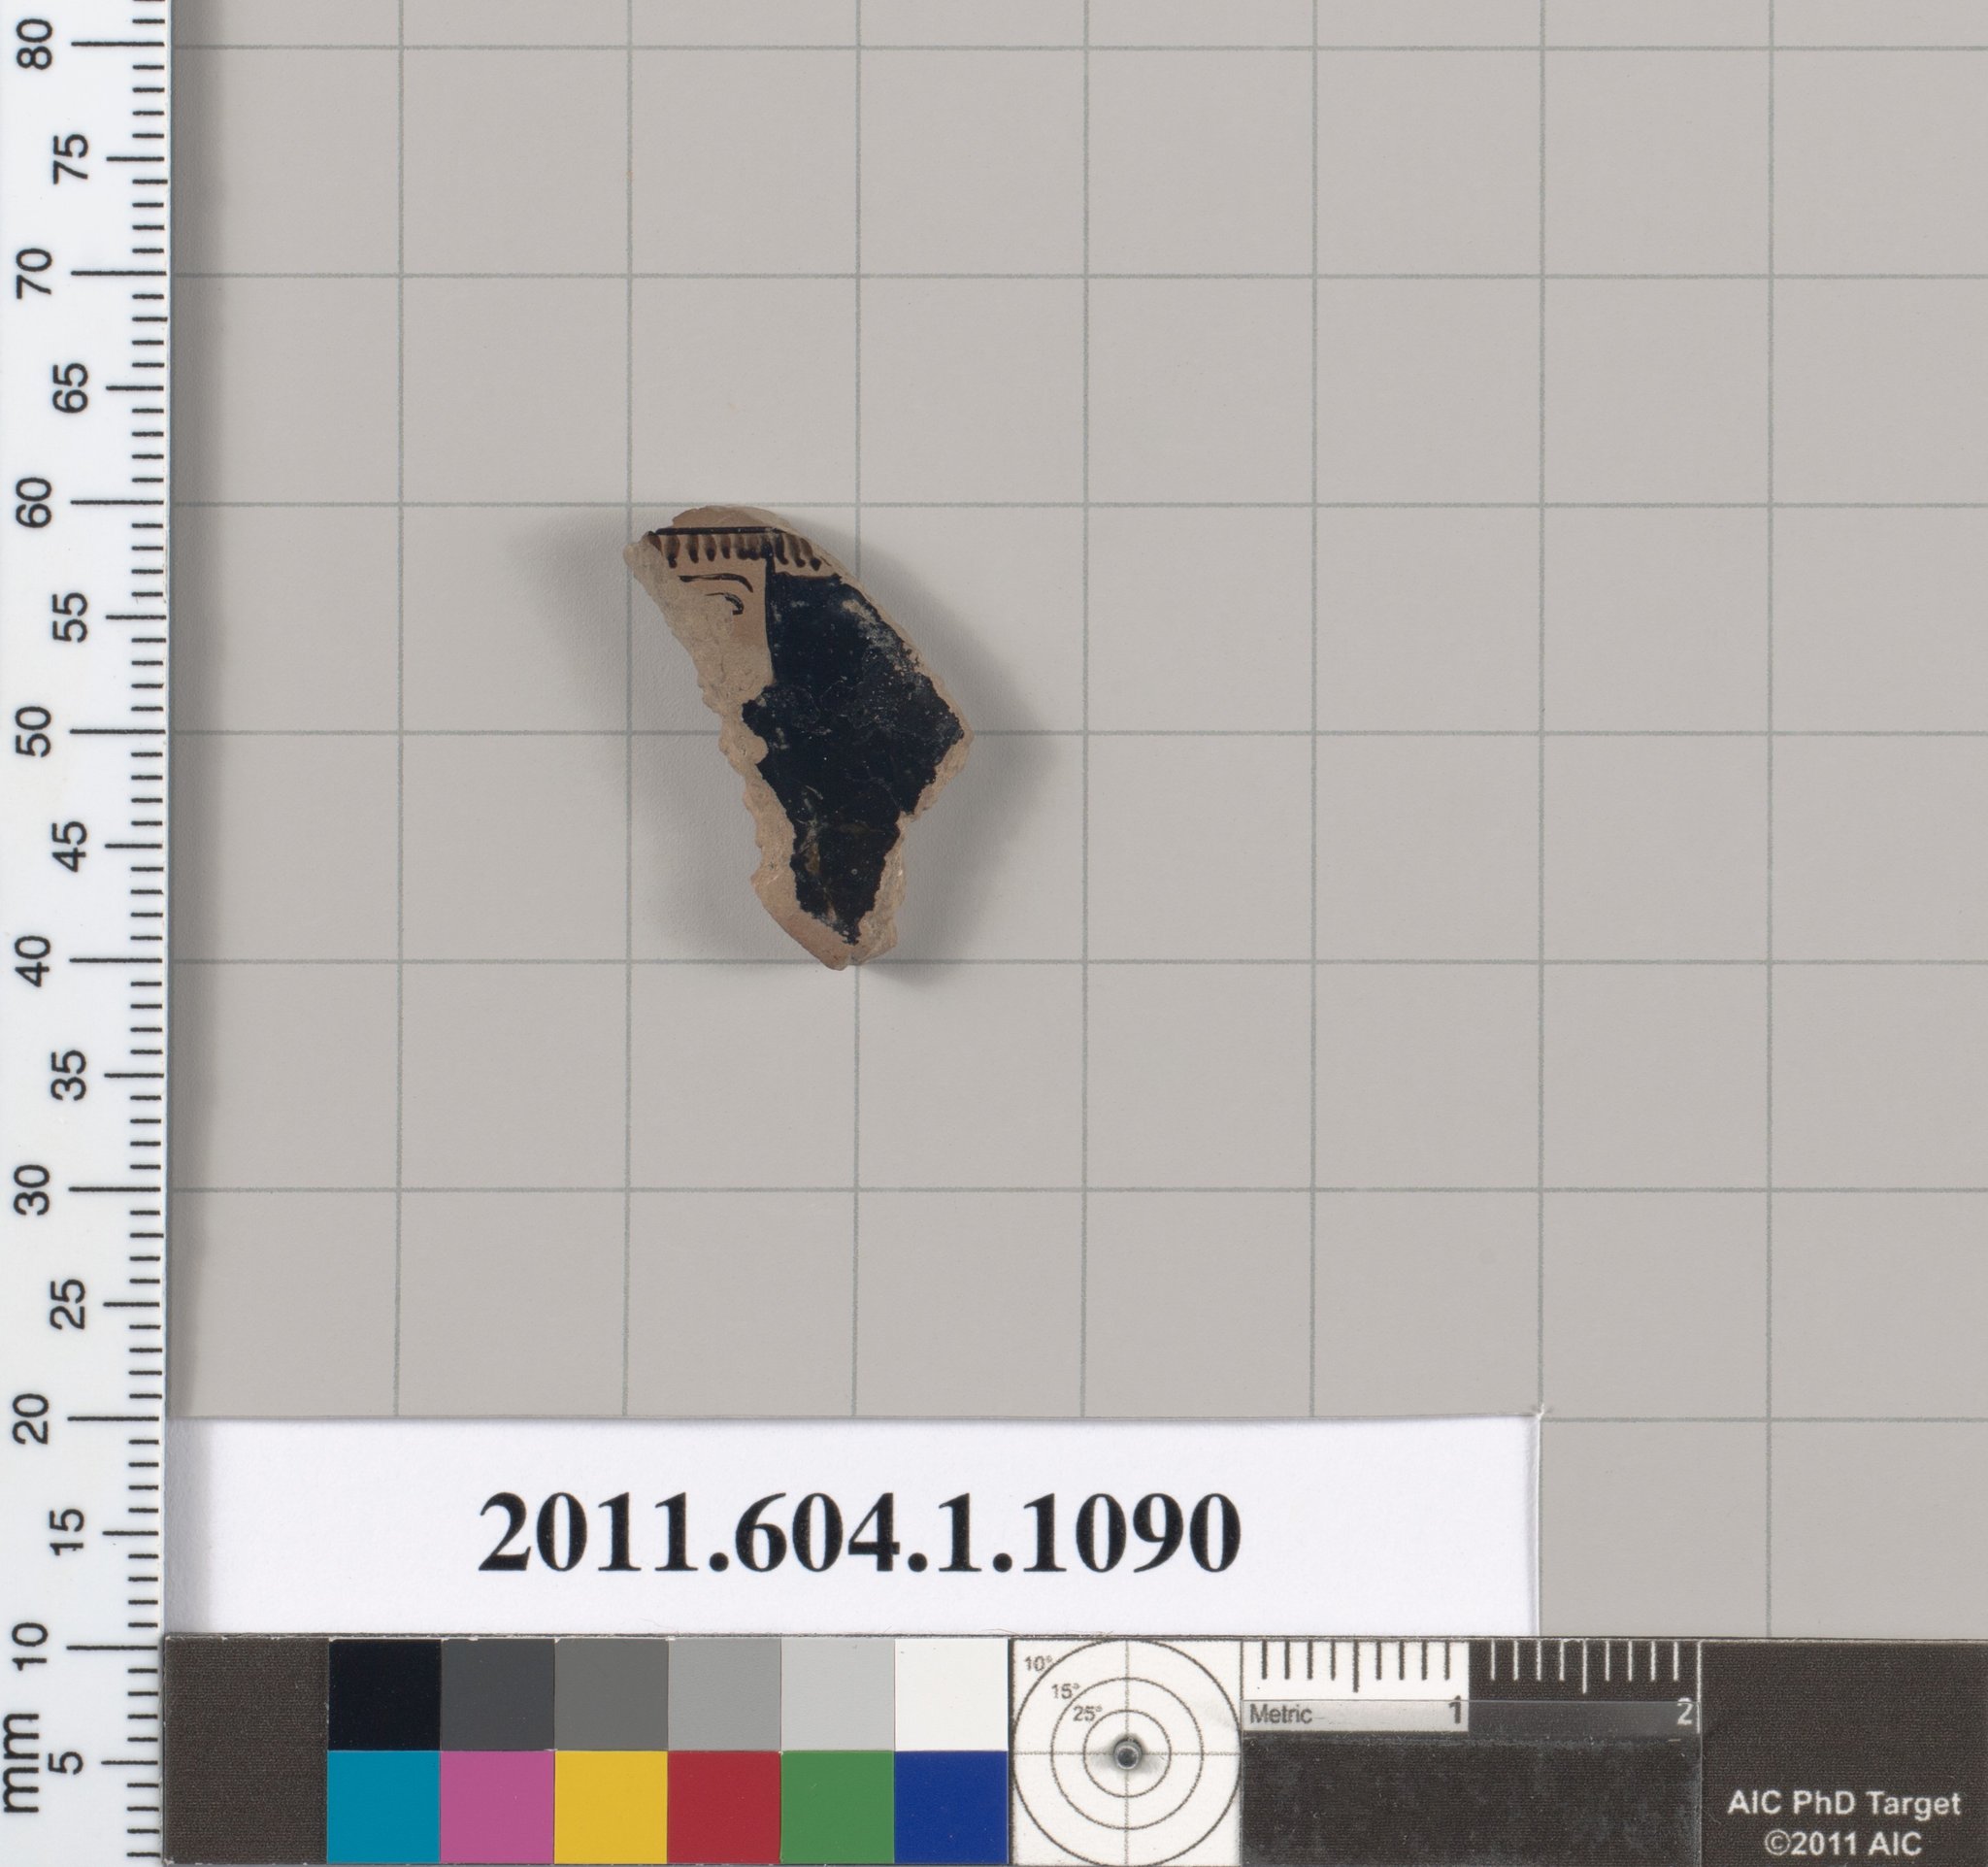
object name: kylix fragment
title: Terracotta fragment of a kylix (drinking cup)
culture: greek, attic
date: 475-451 BCE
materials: terracotta